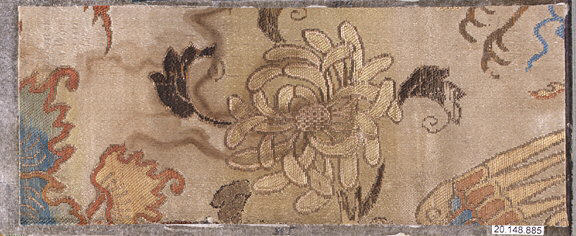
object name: piece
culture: chinese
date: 1601-1700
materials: silk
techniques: compound weave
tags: flowers